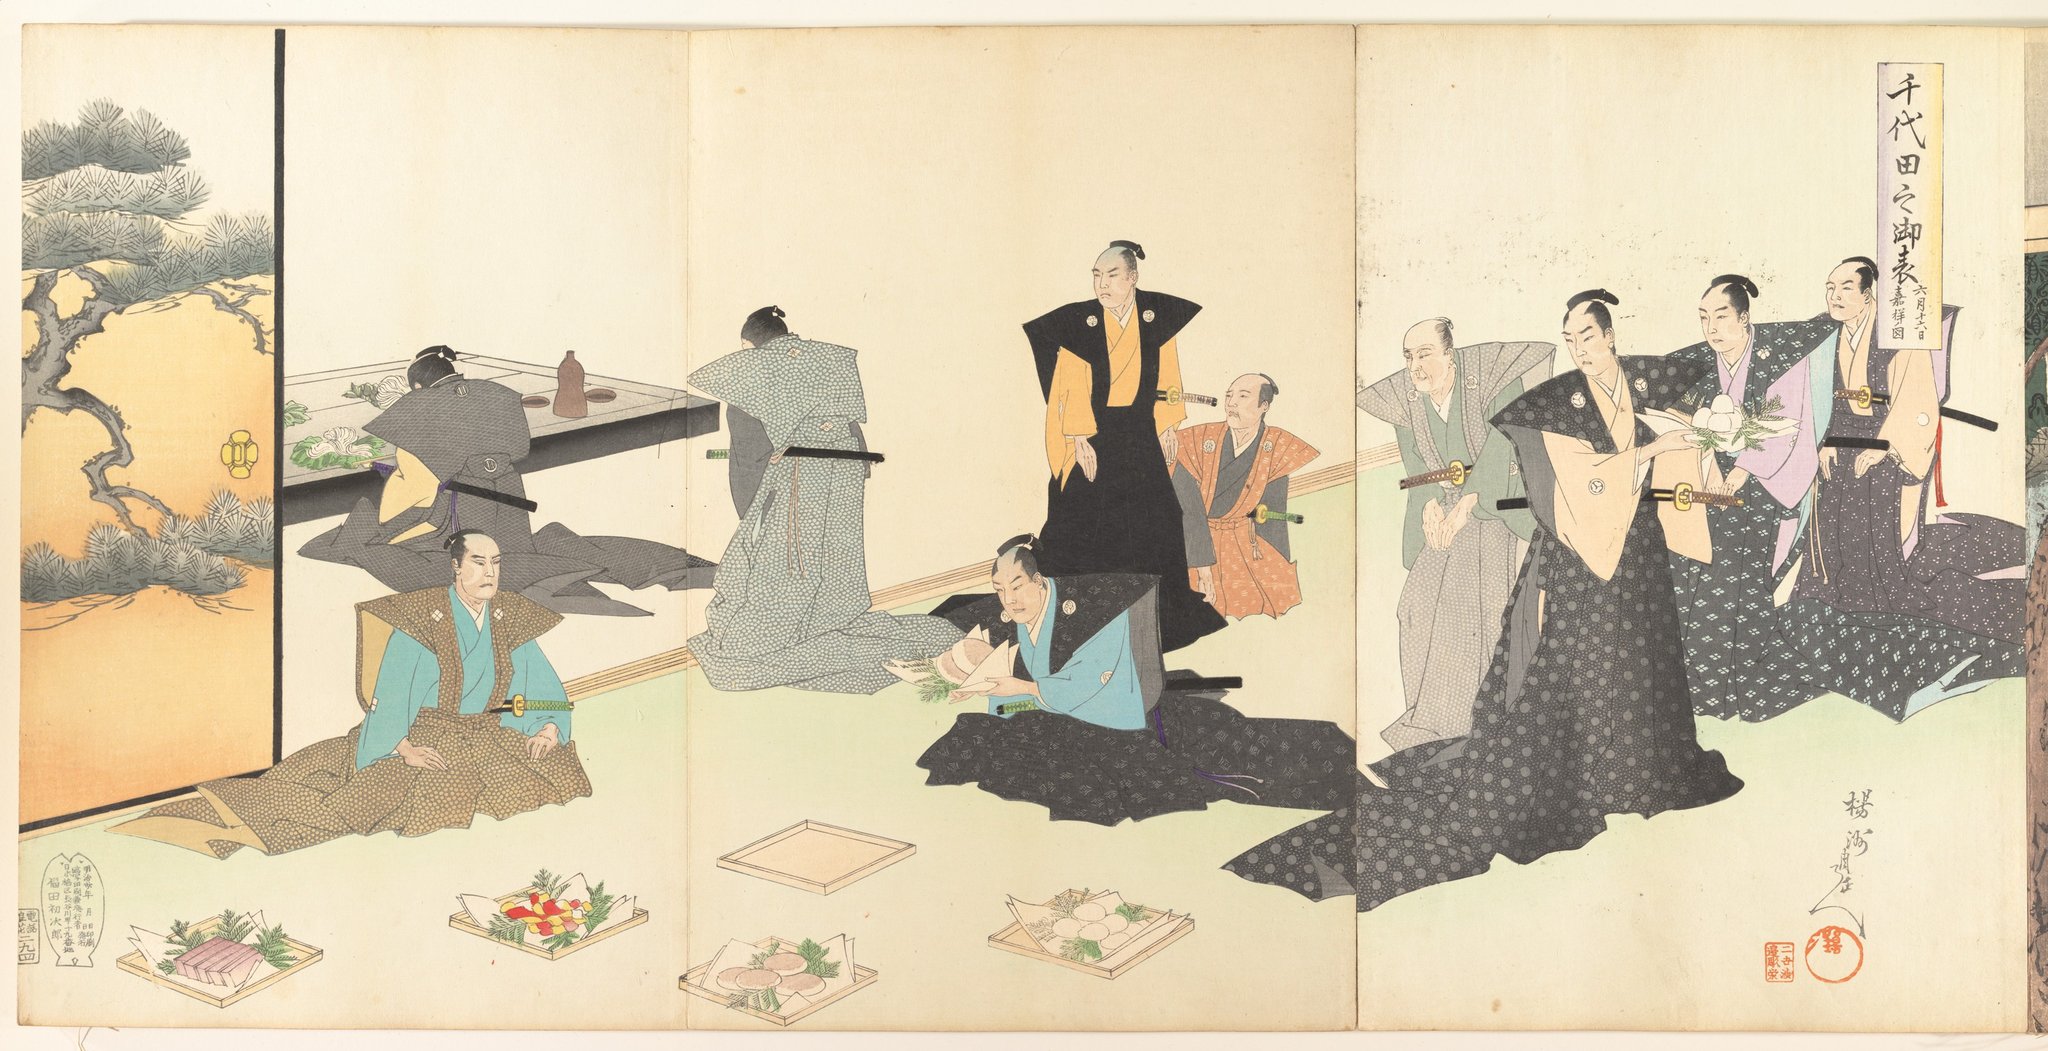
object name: print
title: Chiyoda Castle (Album of Men)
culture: japanese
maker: yōshū (hashimoto) chikanobu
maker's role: artist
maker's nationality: japanese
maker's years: 1838-1912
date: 1897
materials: ink, paper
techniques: woodblock print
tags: weapons,men,trees